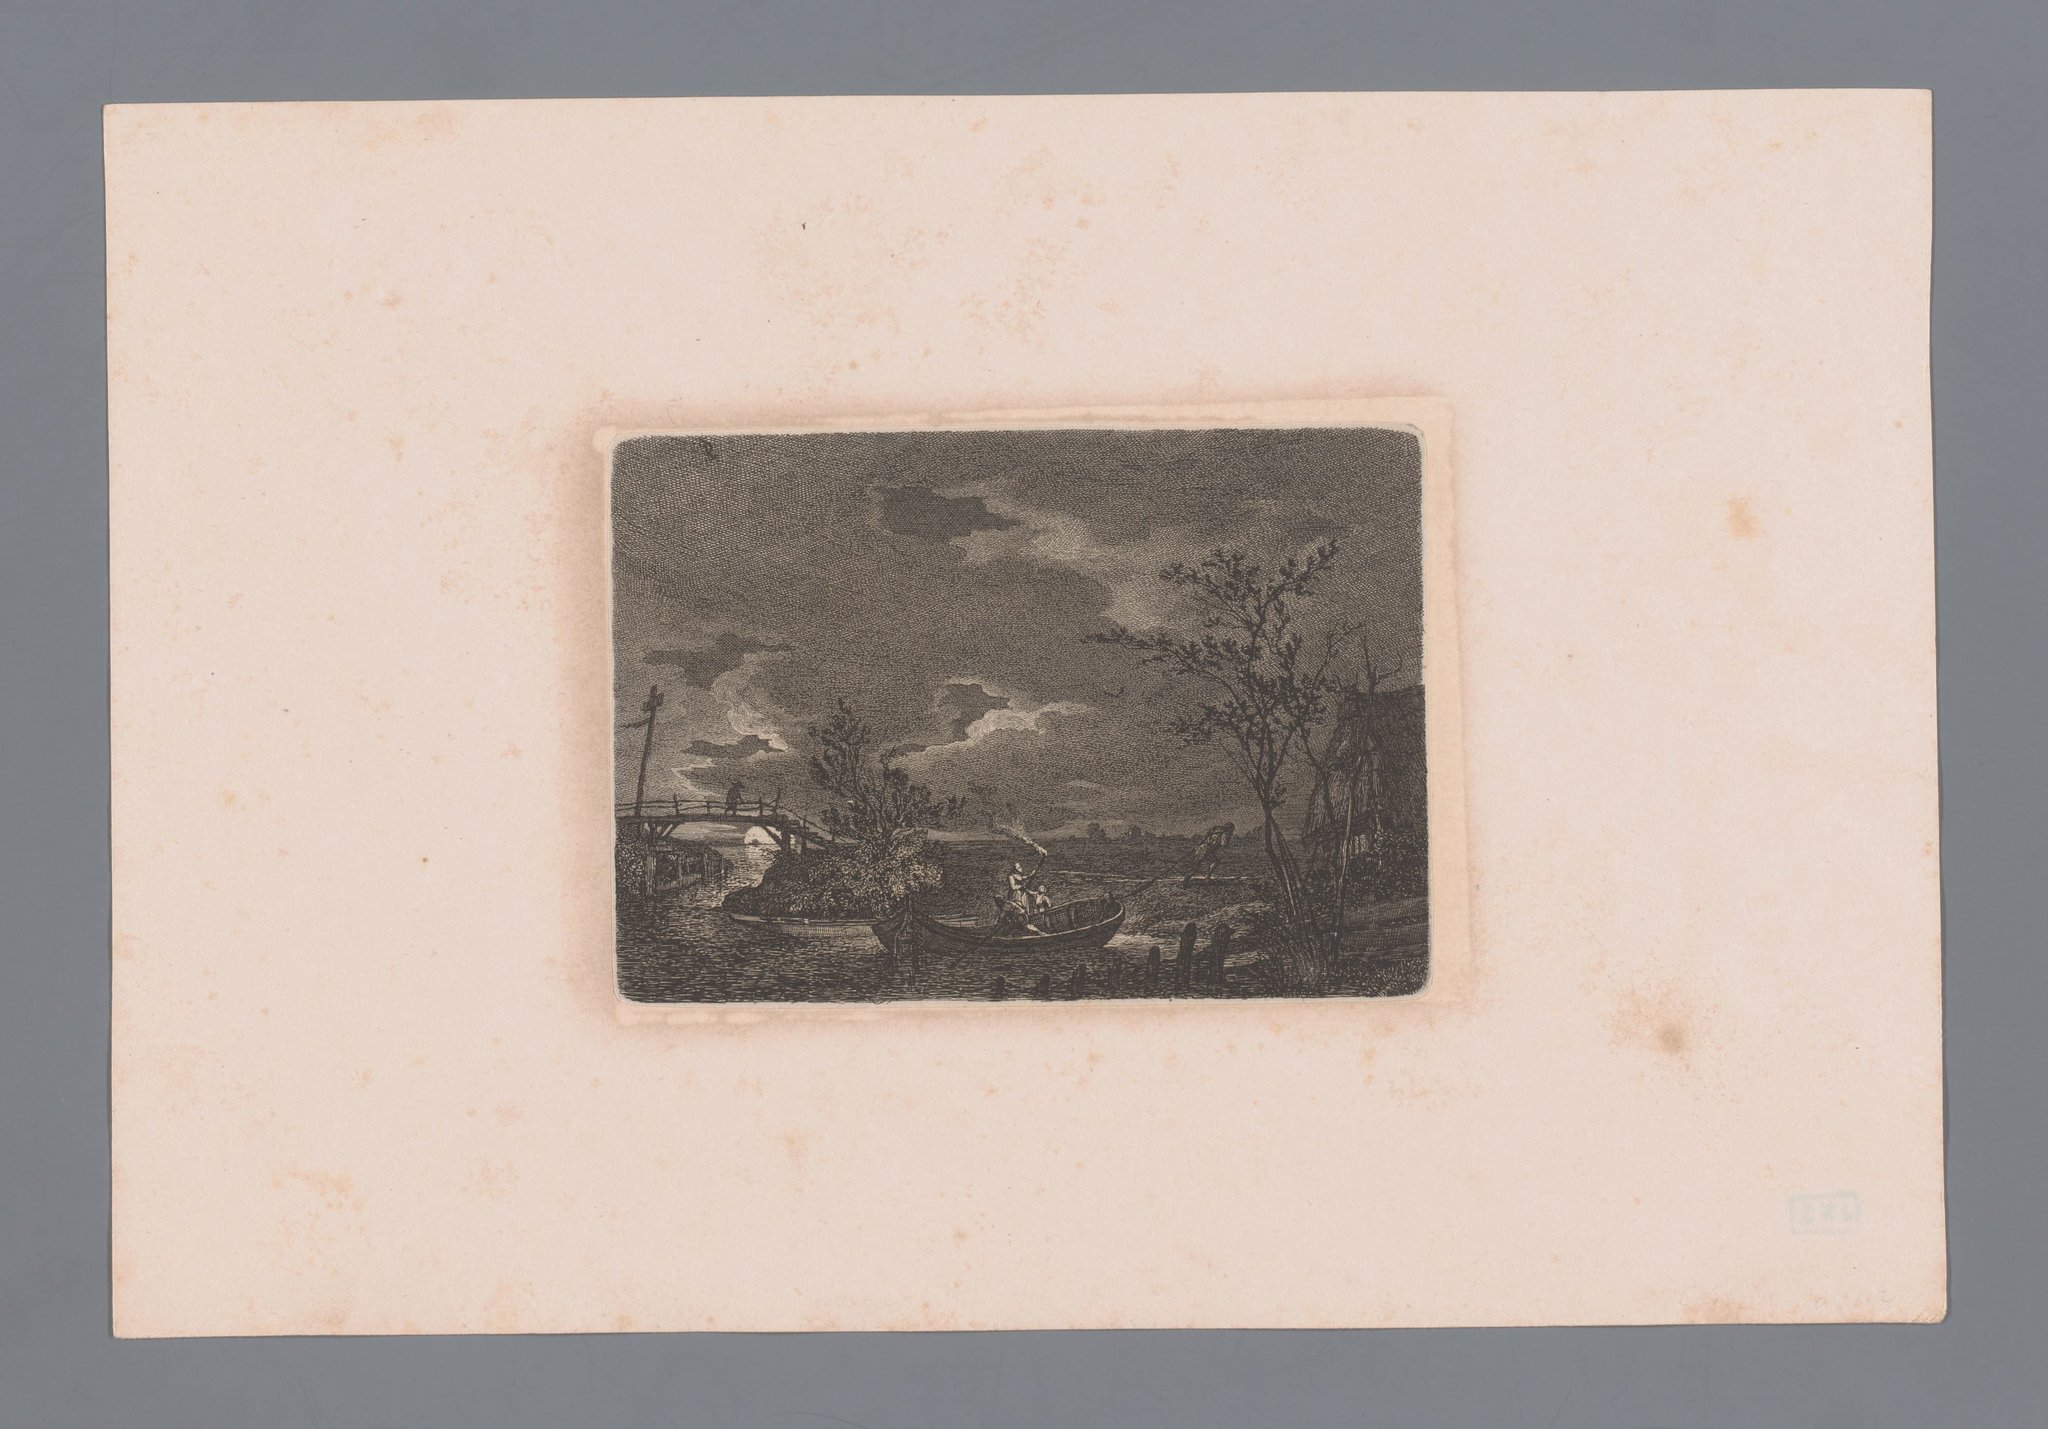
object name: print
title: Nachtstücke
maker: carl august lebschee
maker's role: draughtsman, painter, print maker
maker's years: 1800-1877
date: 1827-1828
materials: paper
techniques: etching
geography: munich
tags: rowing-boat, canoe, etc., night ~ landscape (sometimes titled 'nox'), river (+ landscape with figures, staffage)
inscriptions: collector's mark: Lugt 2760, collector's mark: Lugt 3976, collector's mark: Lugt 2228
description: Nachtelijk landschap met kleine rivier. Op de voorgrond een boot met een roeiende man. Aan de oever bevinden zich een man met een fakkel en een kind en een man die de boot voorttrekt. Links op de achtergrond een brug met daarnaast een kruis en in de verte een volle maan.